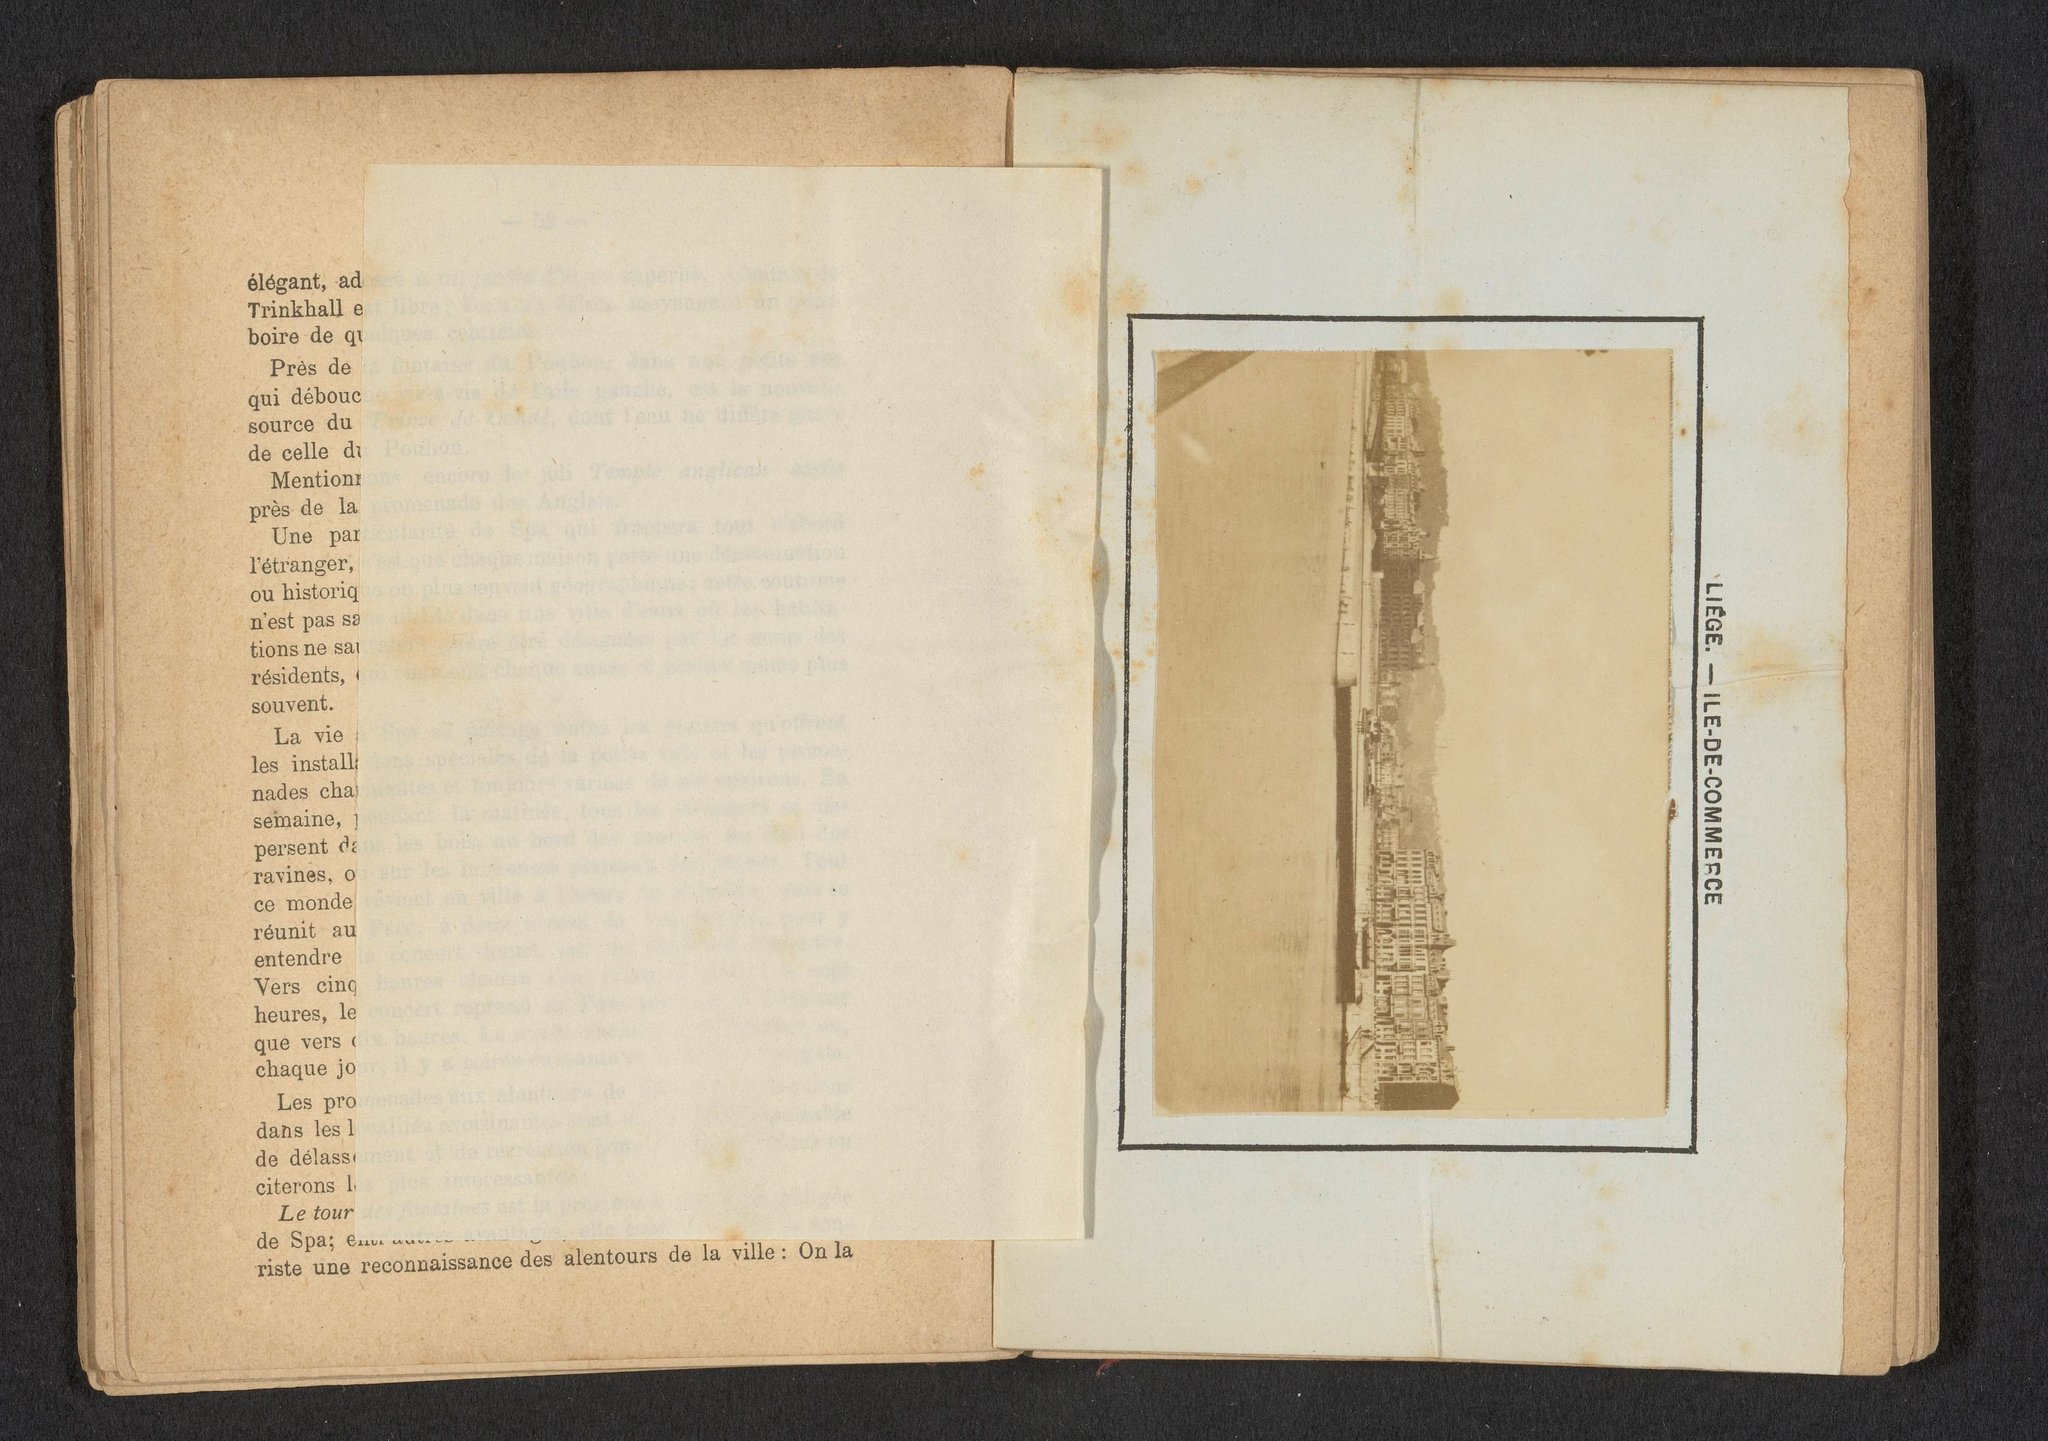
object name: page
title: Liège, ile-de-commerce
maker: Anonymous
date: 1876-1881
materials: photographic support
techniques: albumen print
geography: liège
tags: city-view in general; 'veduta', river, liège